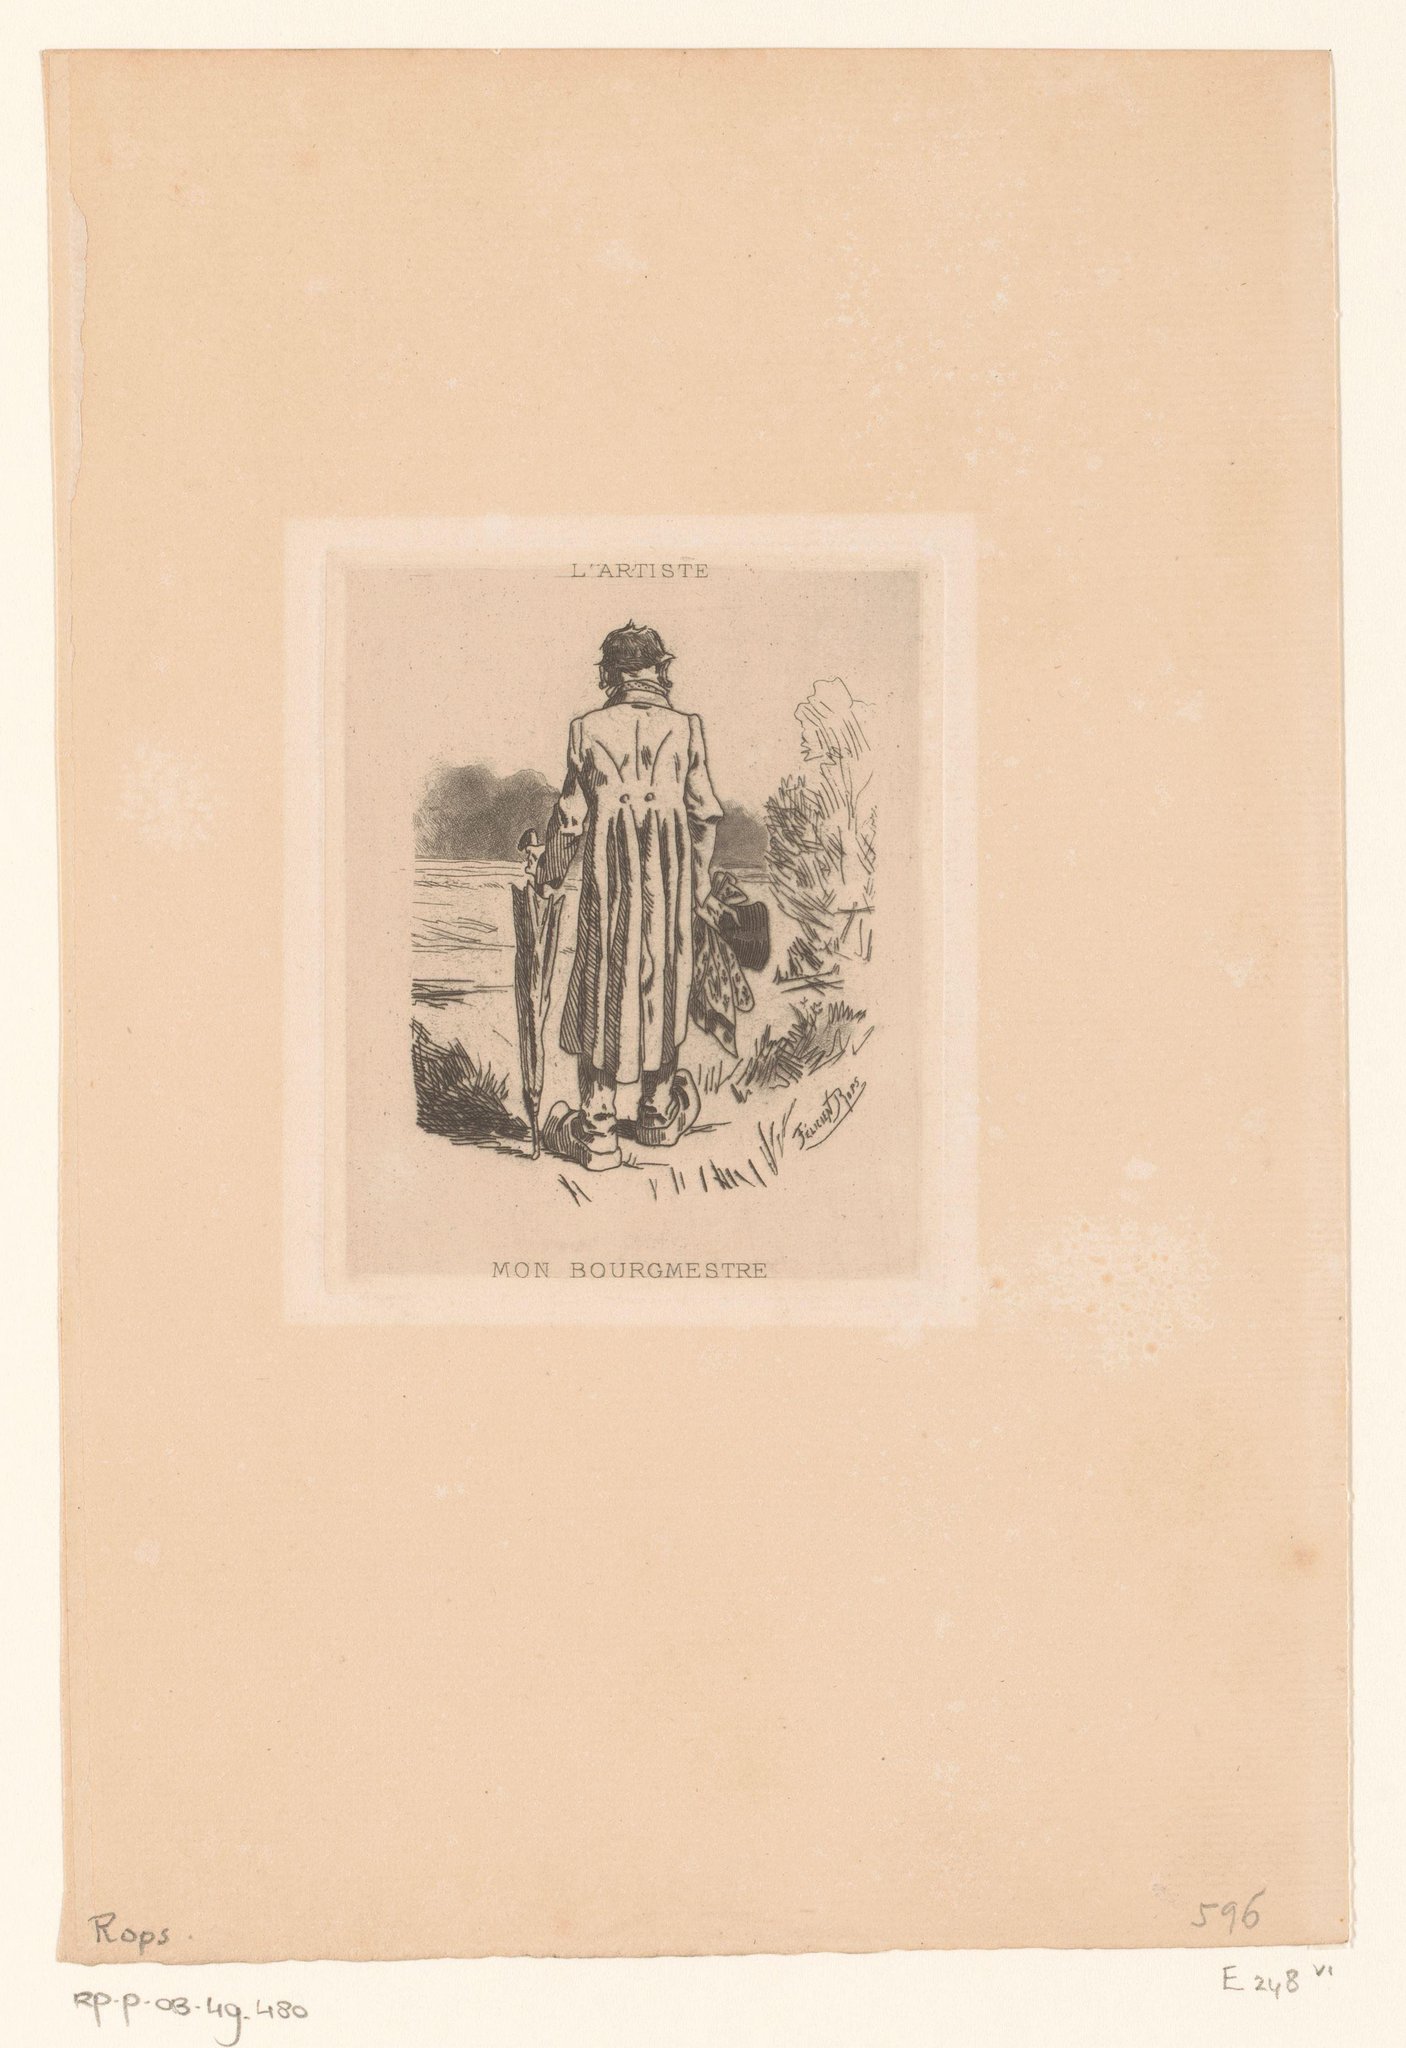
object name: print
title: Mon Bourgmestre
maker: félicien rops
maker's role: draughtsman, print maker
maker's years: 1833-1898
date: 1874-1893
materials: paper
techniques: aquatint, etching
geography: paris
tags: adult man (+ back view)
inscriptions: collector's mark: Lugt 2228